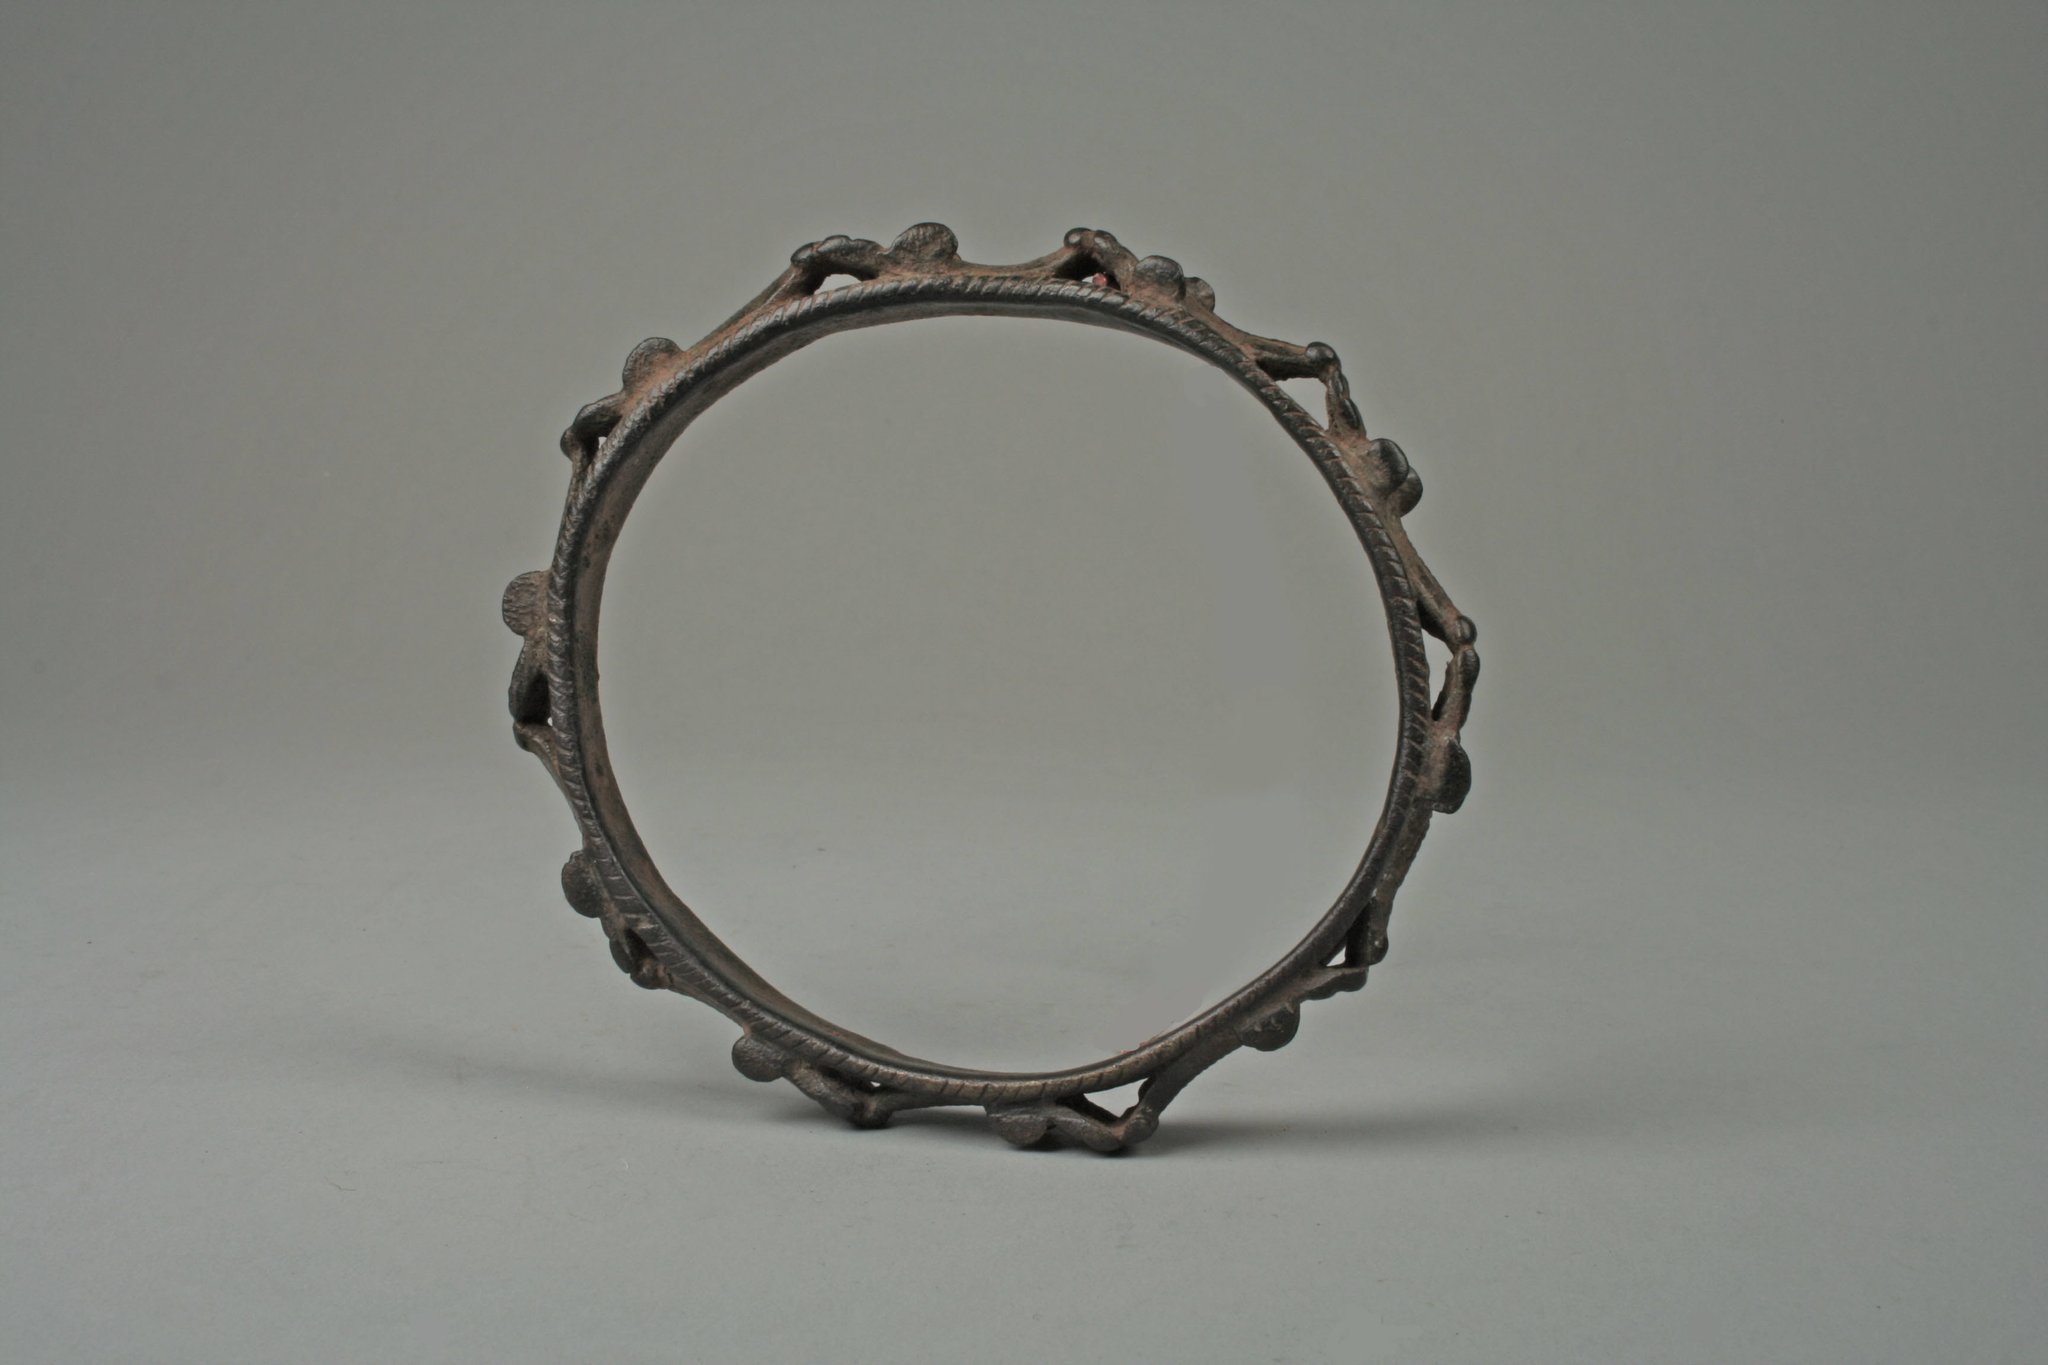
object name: bracelet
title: Bracelet: Crocodile Heads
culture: edo period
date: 1501-1900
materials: brass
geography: nigeria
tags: crocodiles